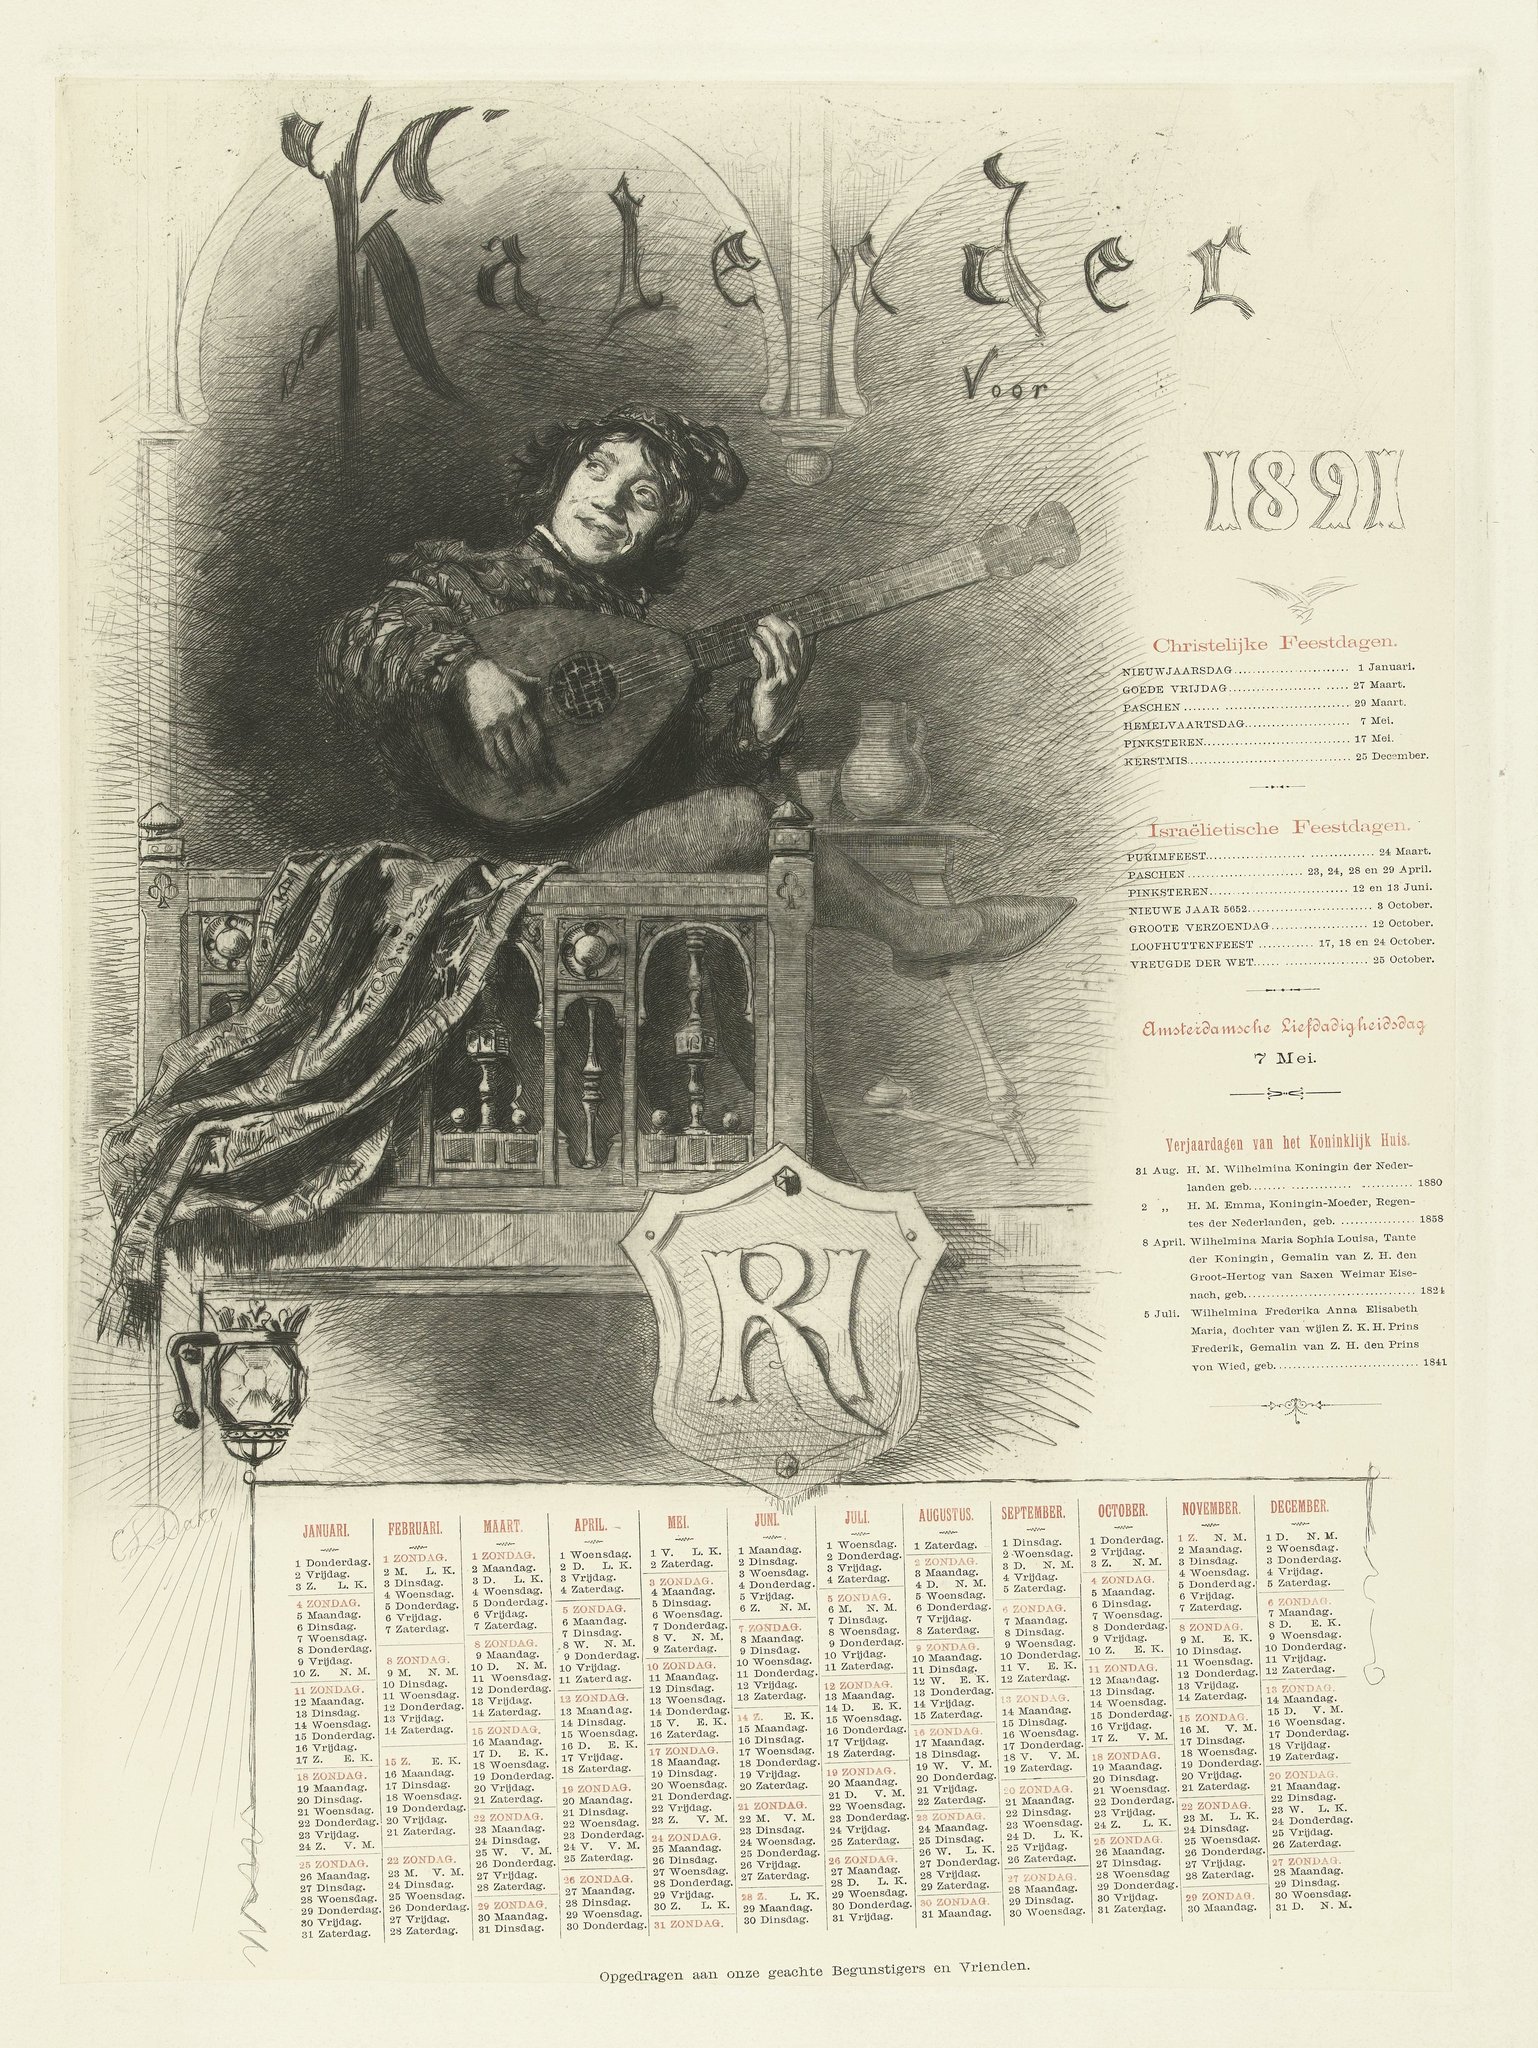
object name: print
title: Kalender voor 1891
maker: carel lodewijk dake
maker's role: draughtsman, painter, print maker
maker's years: 1857-1918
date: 1890-1891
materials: paper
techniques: drypoint, etching, intaglio, letterpress printing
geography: netherlands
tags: calendar, almanac, making music; musician with instrument, lute, and special forms of lute, e.g.: theorbo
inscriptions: collector's mark: Lugt 2228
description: Kalender voor 1891 met vrolijke man, gekleed in zeventiende eeuws kostuum, die speelt op een luit. Enkele feestdagen worden specifiek genoemd en bij de kalender zijn, behalve maanden en dagen, met afkortingen de maanstanden vermeld. Op een schild staat een monogram R&H dat verwijst naar de organisatie welke de kalender opdraagt aan haar begunstigers en vrienden aldus het opschrift.